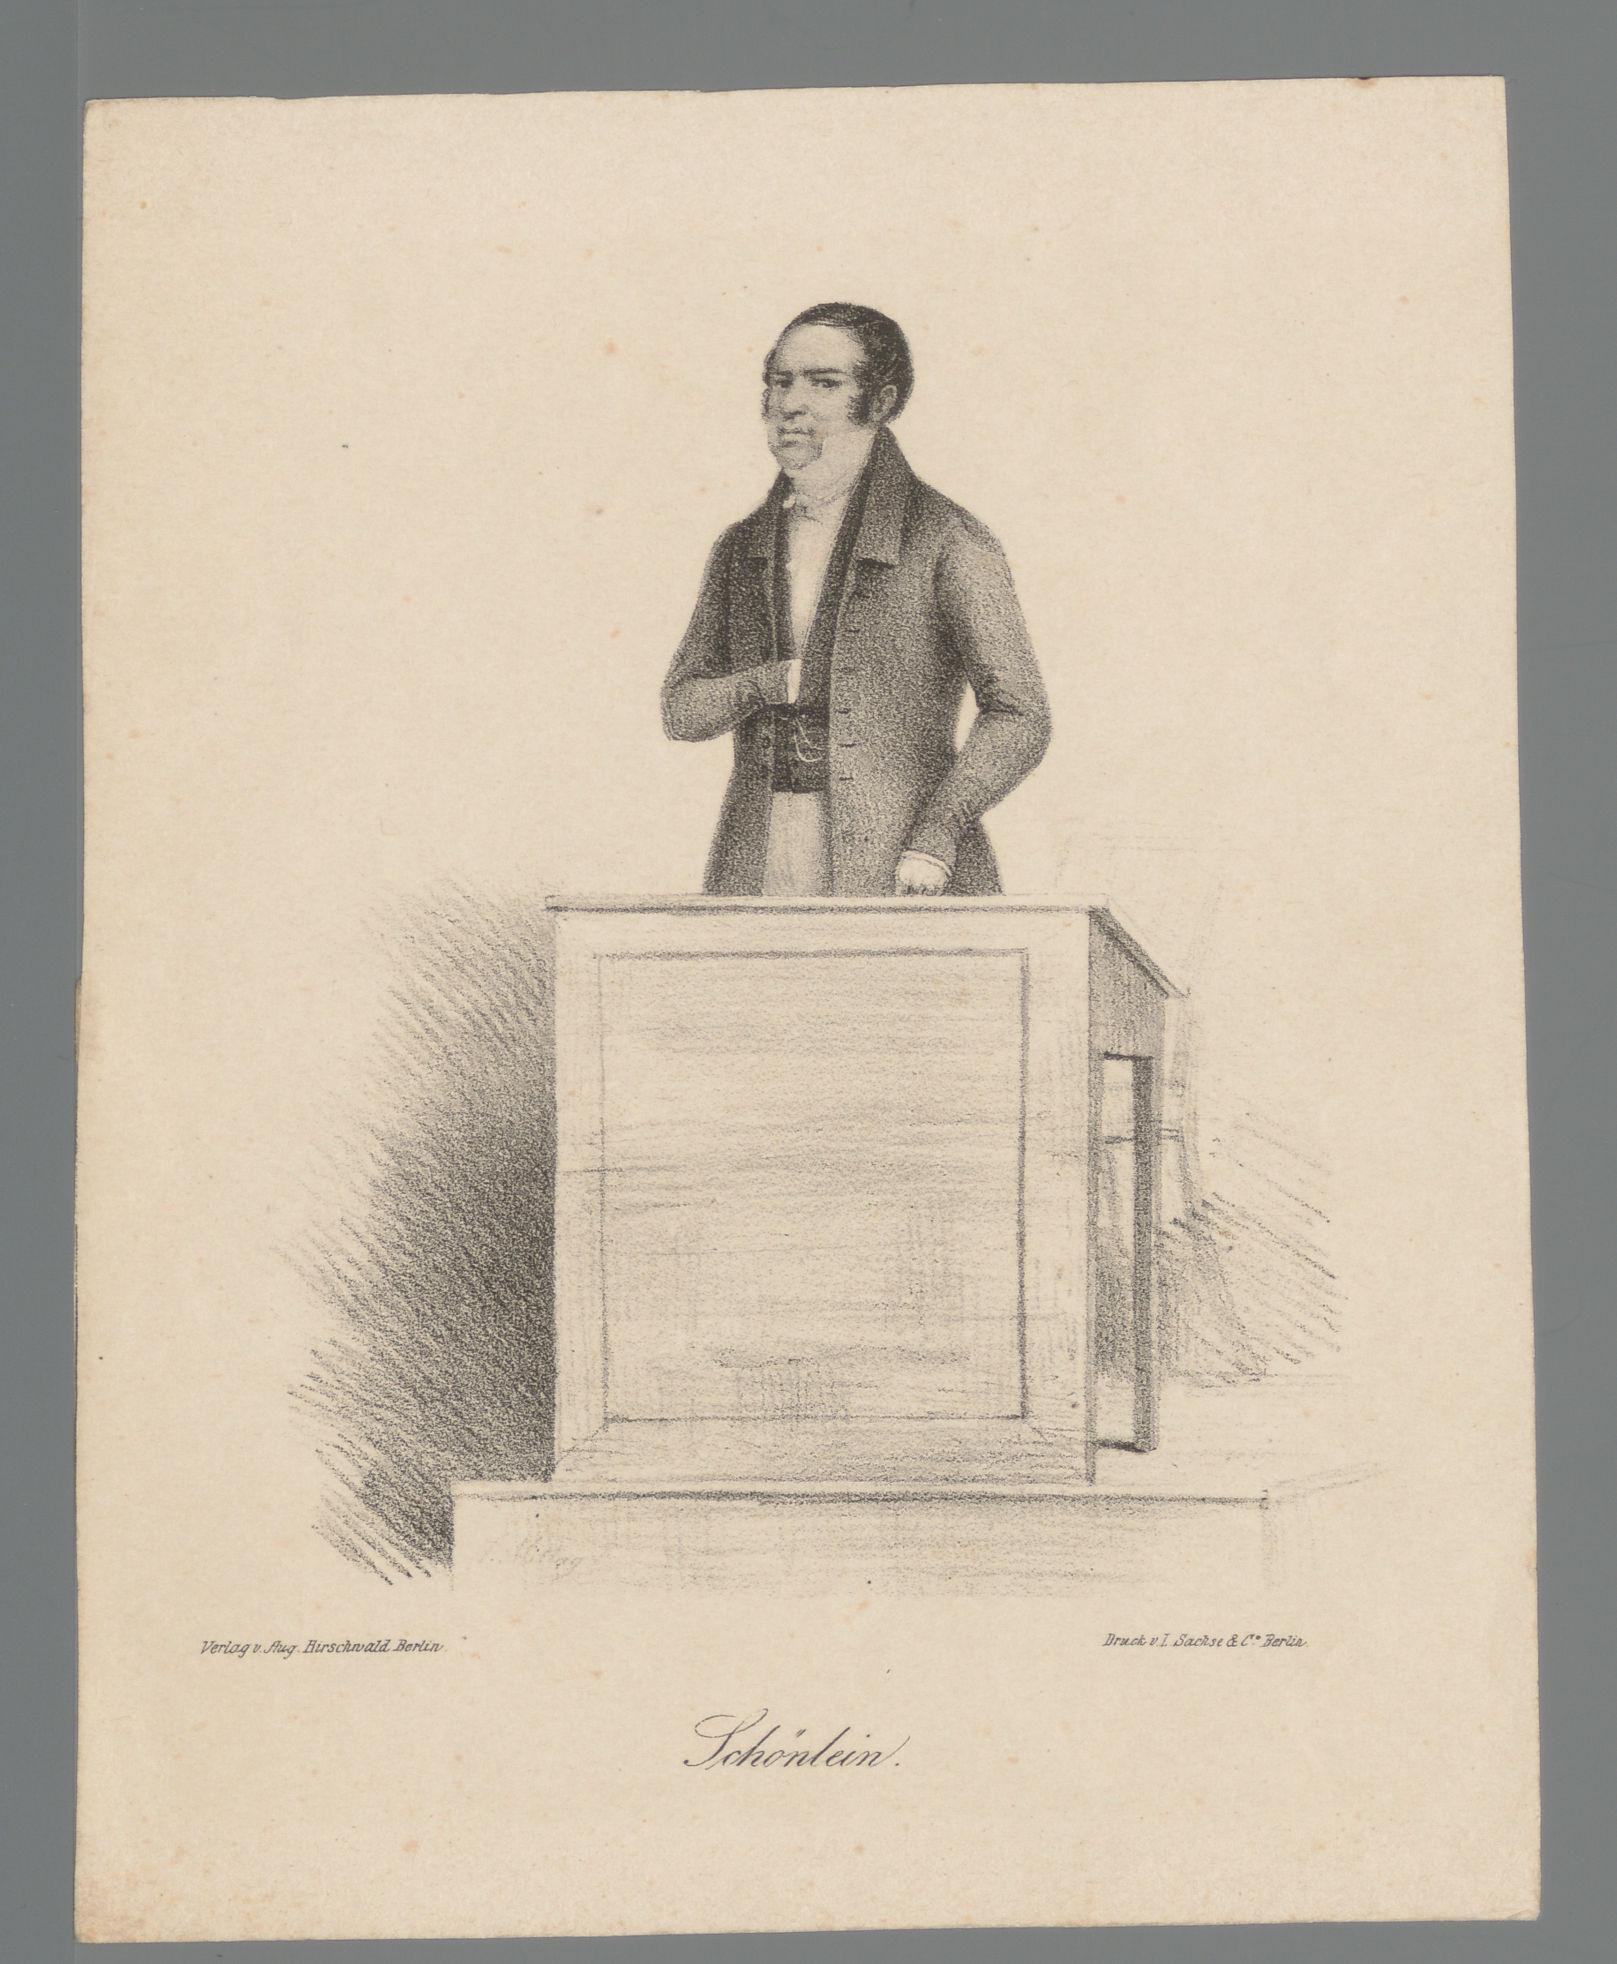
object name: print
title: Schönlein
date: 1825-1875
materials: paper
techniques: lithograph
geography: berlin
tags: adult man, historical persons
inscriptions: collector's mark: Lugt 2228